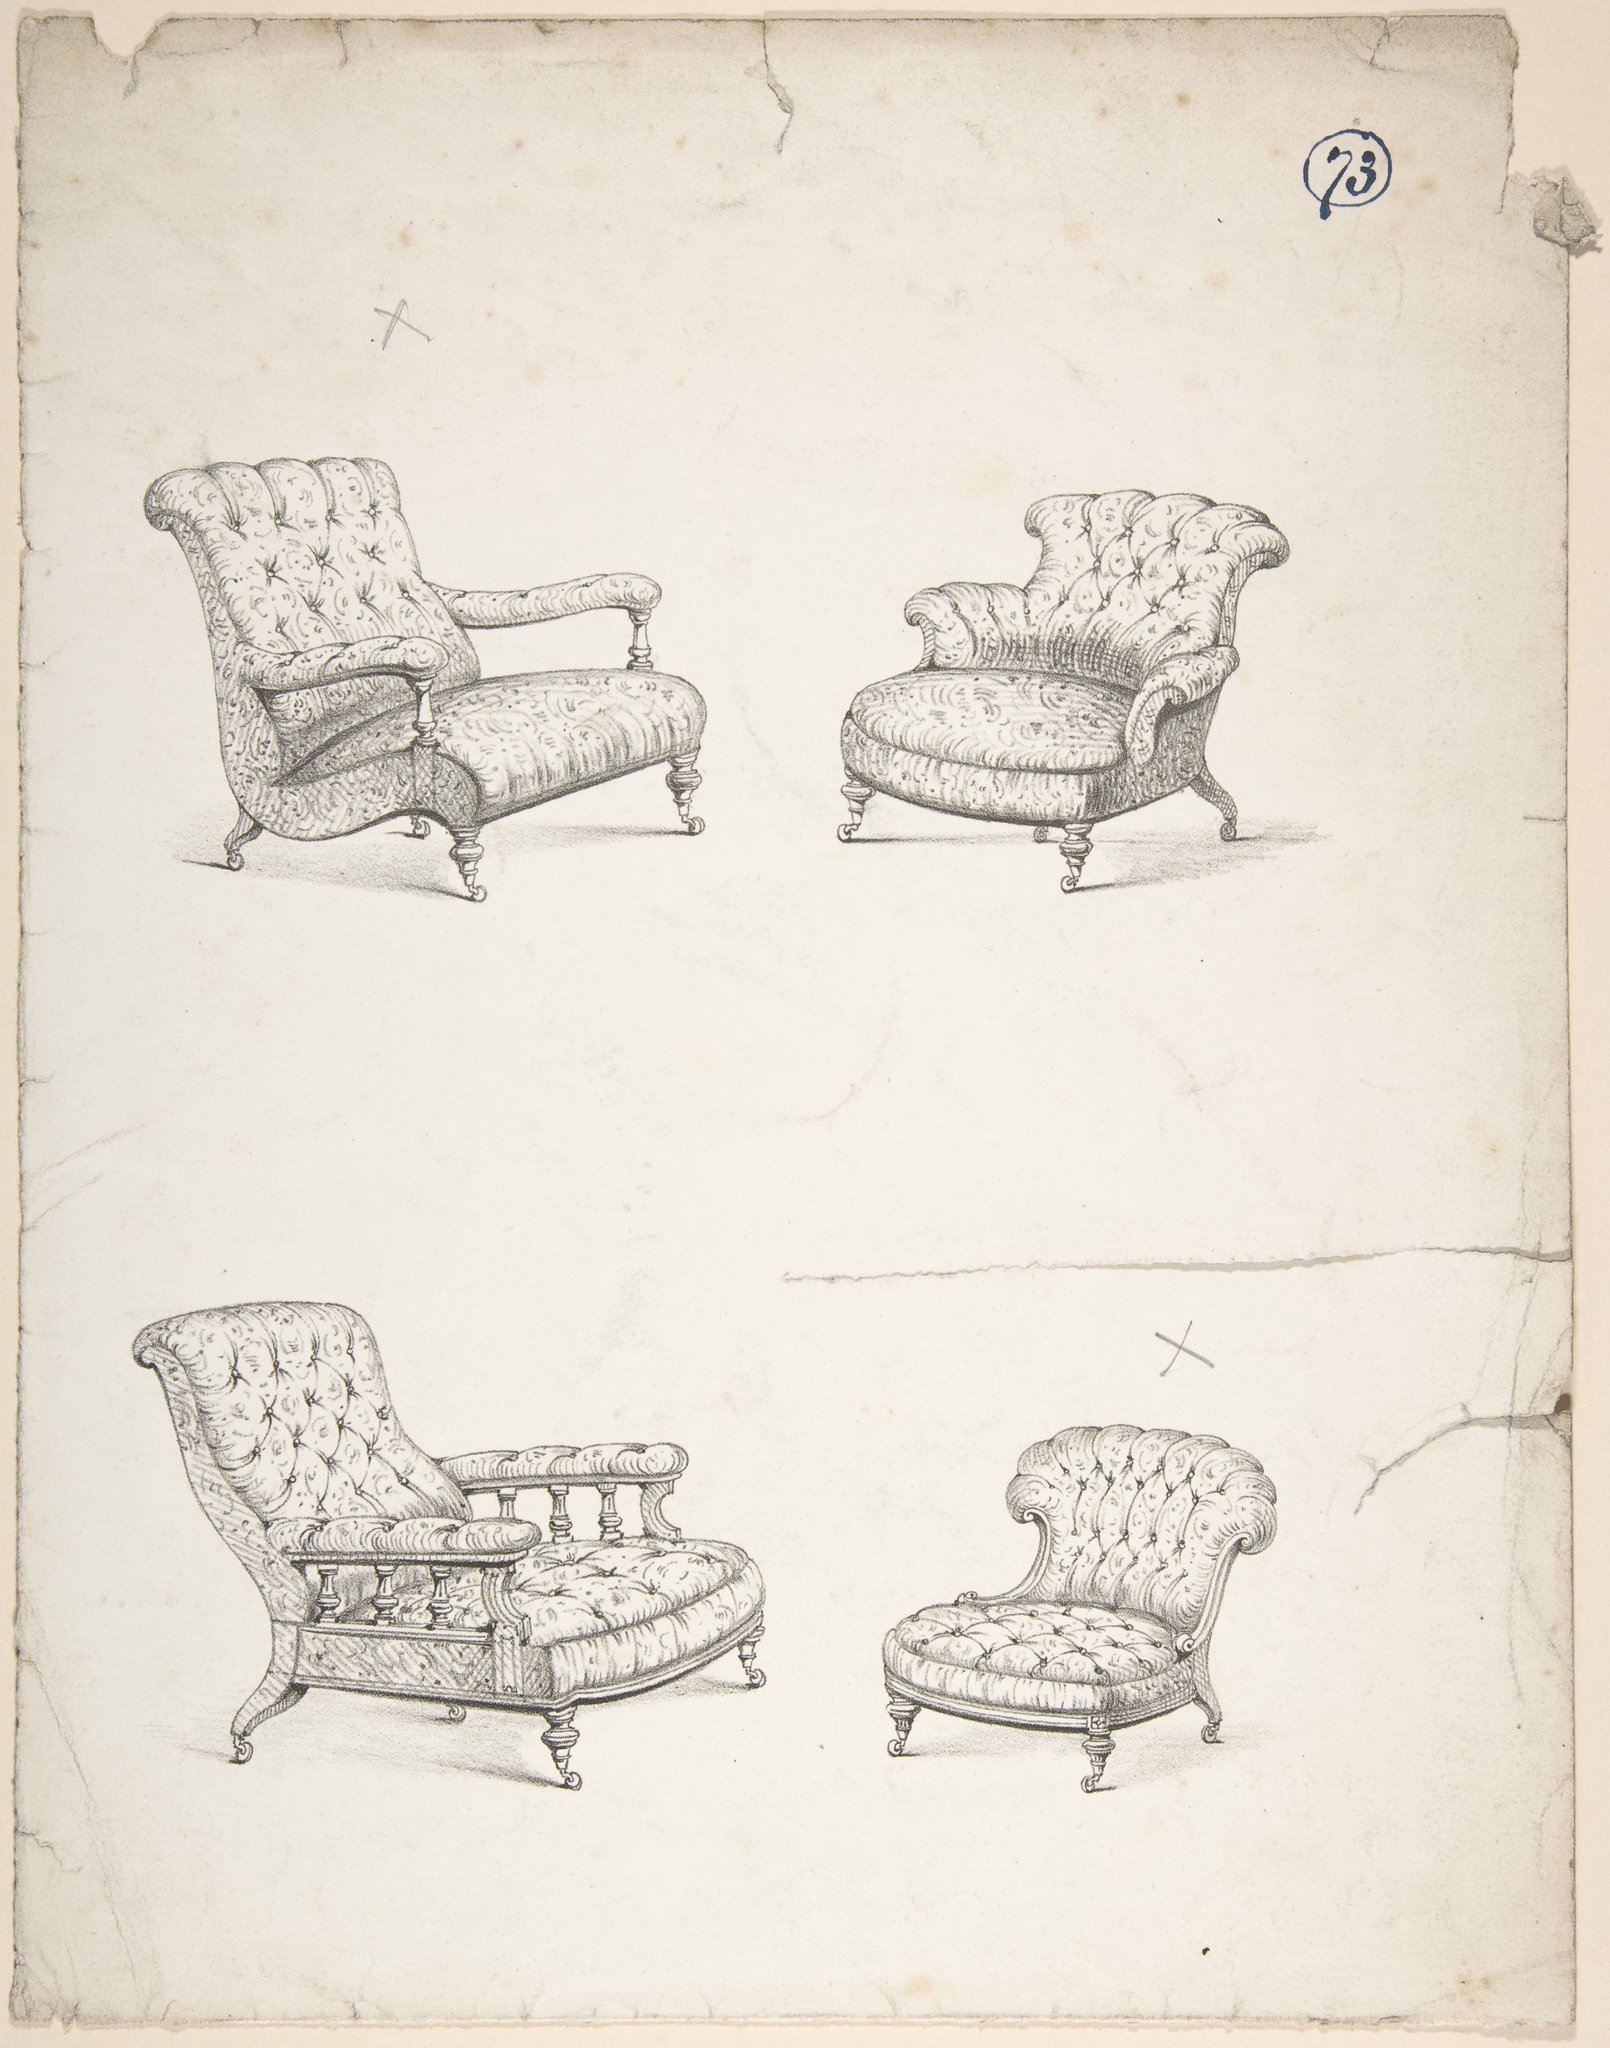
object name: drawing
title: Designs for Four Upholstered Chairs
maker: charles hindley and sons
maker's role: artist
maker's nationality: british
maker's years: 1841-1917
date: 1841-1884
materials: chalk, graphite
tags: chairs